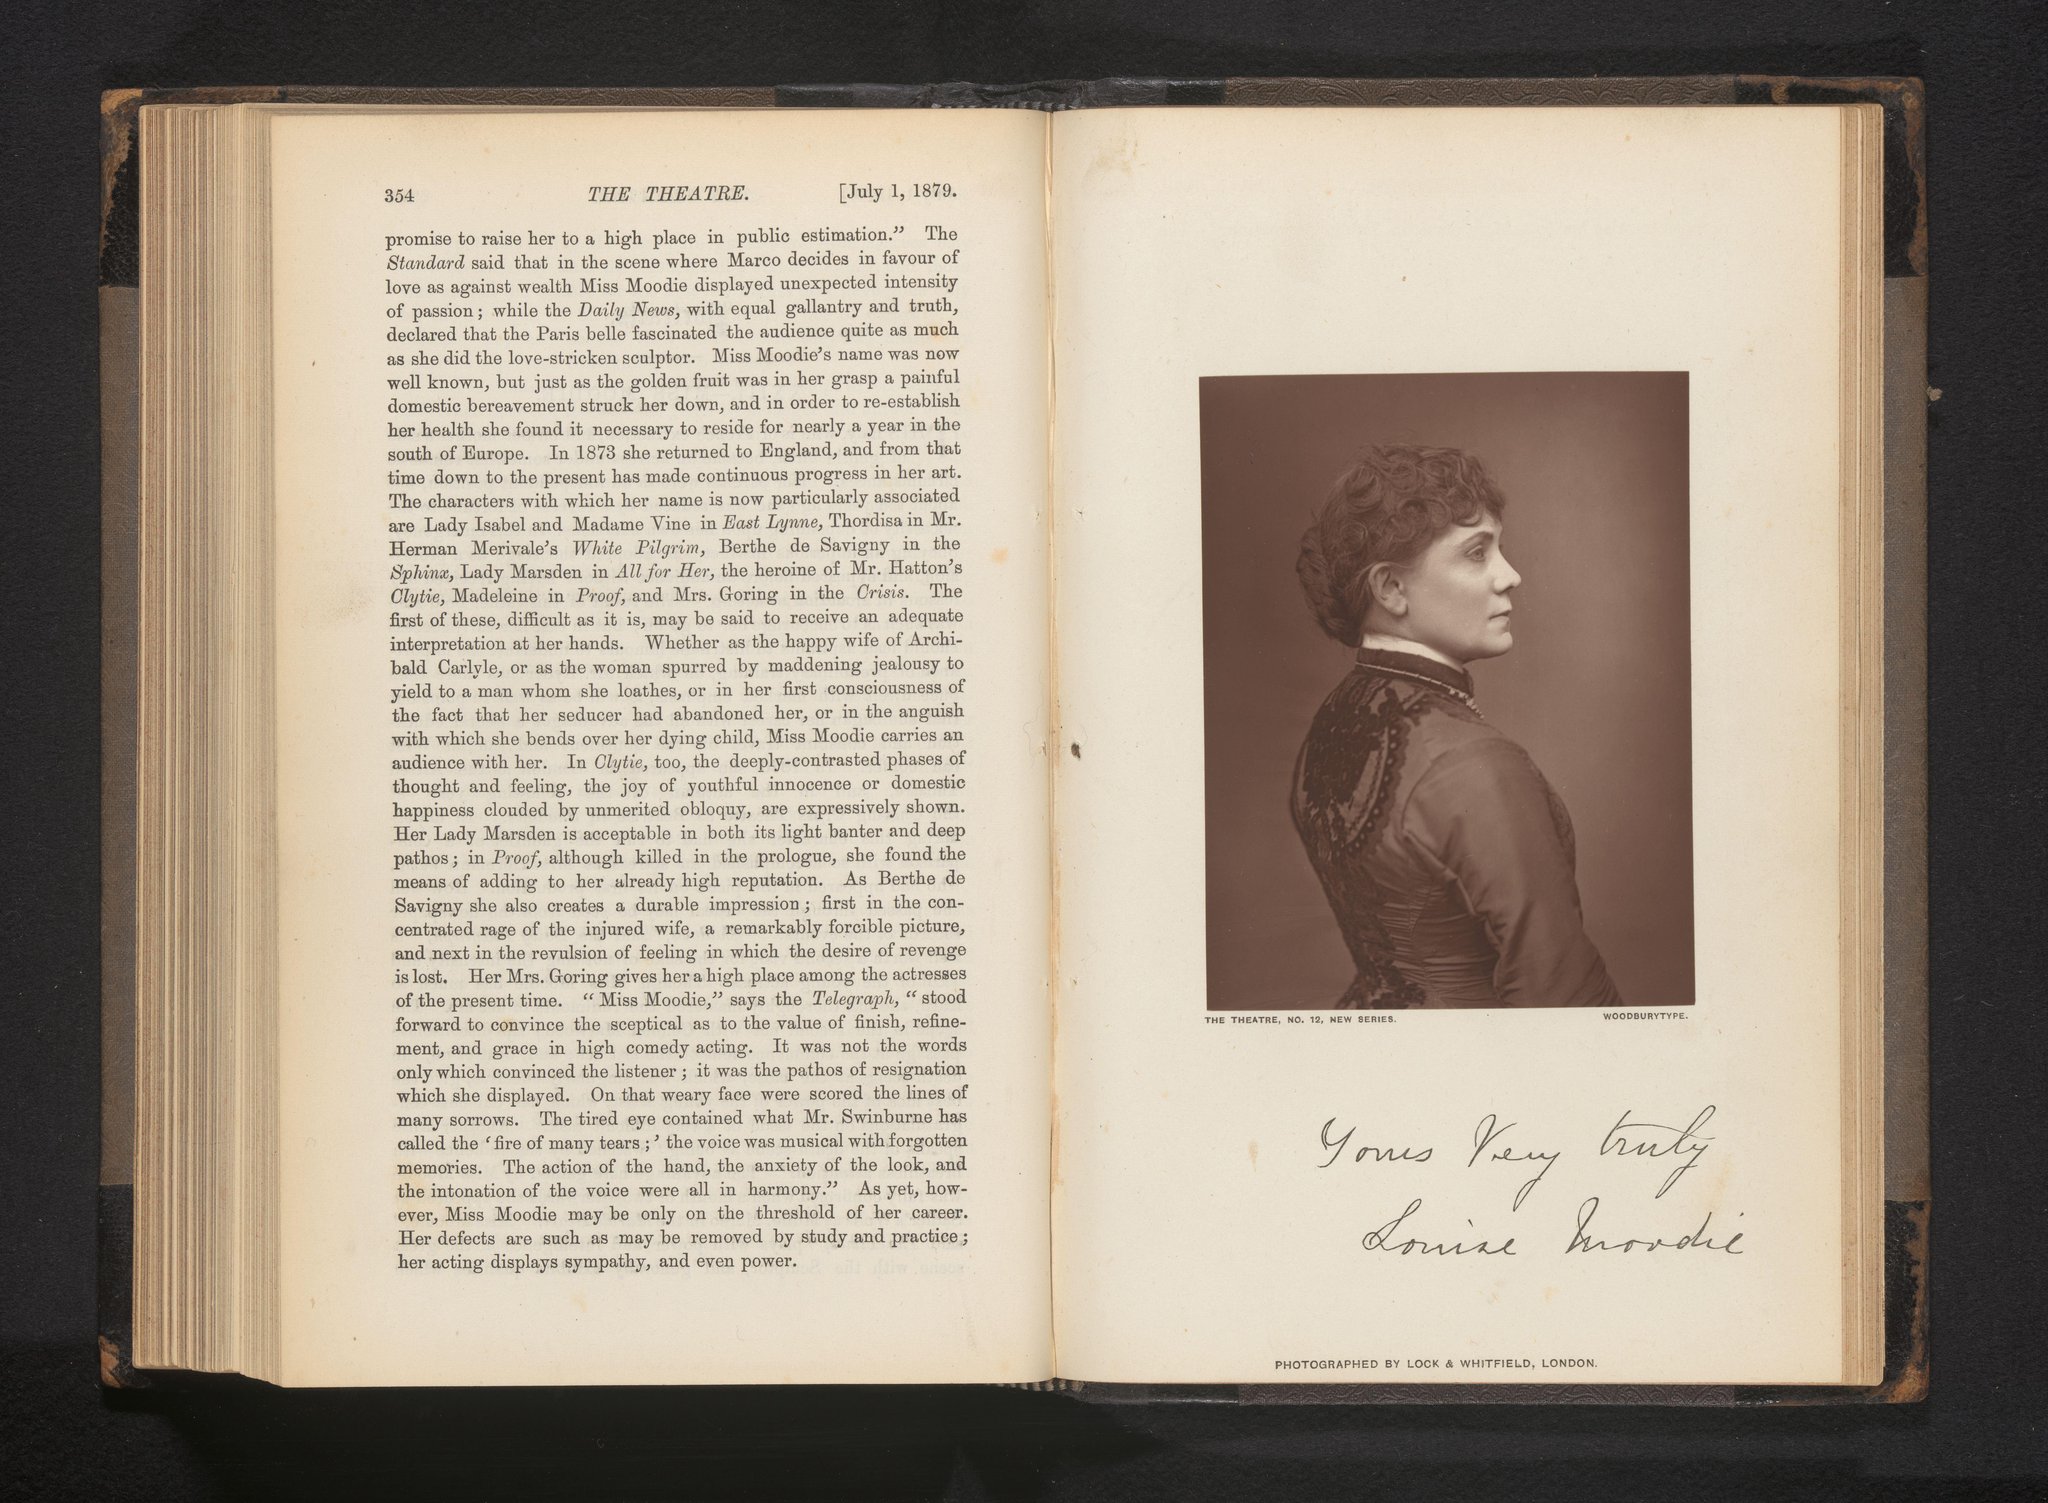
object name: page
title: Portret van Louise Moodie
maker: Anonymous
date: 1874-1879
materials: paper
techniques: woodburytype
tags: adult woman, historical persons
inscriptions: signature: ‘Yours very truly/ Louise Moodie’